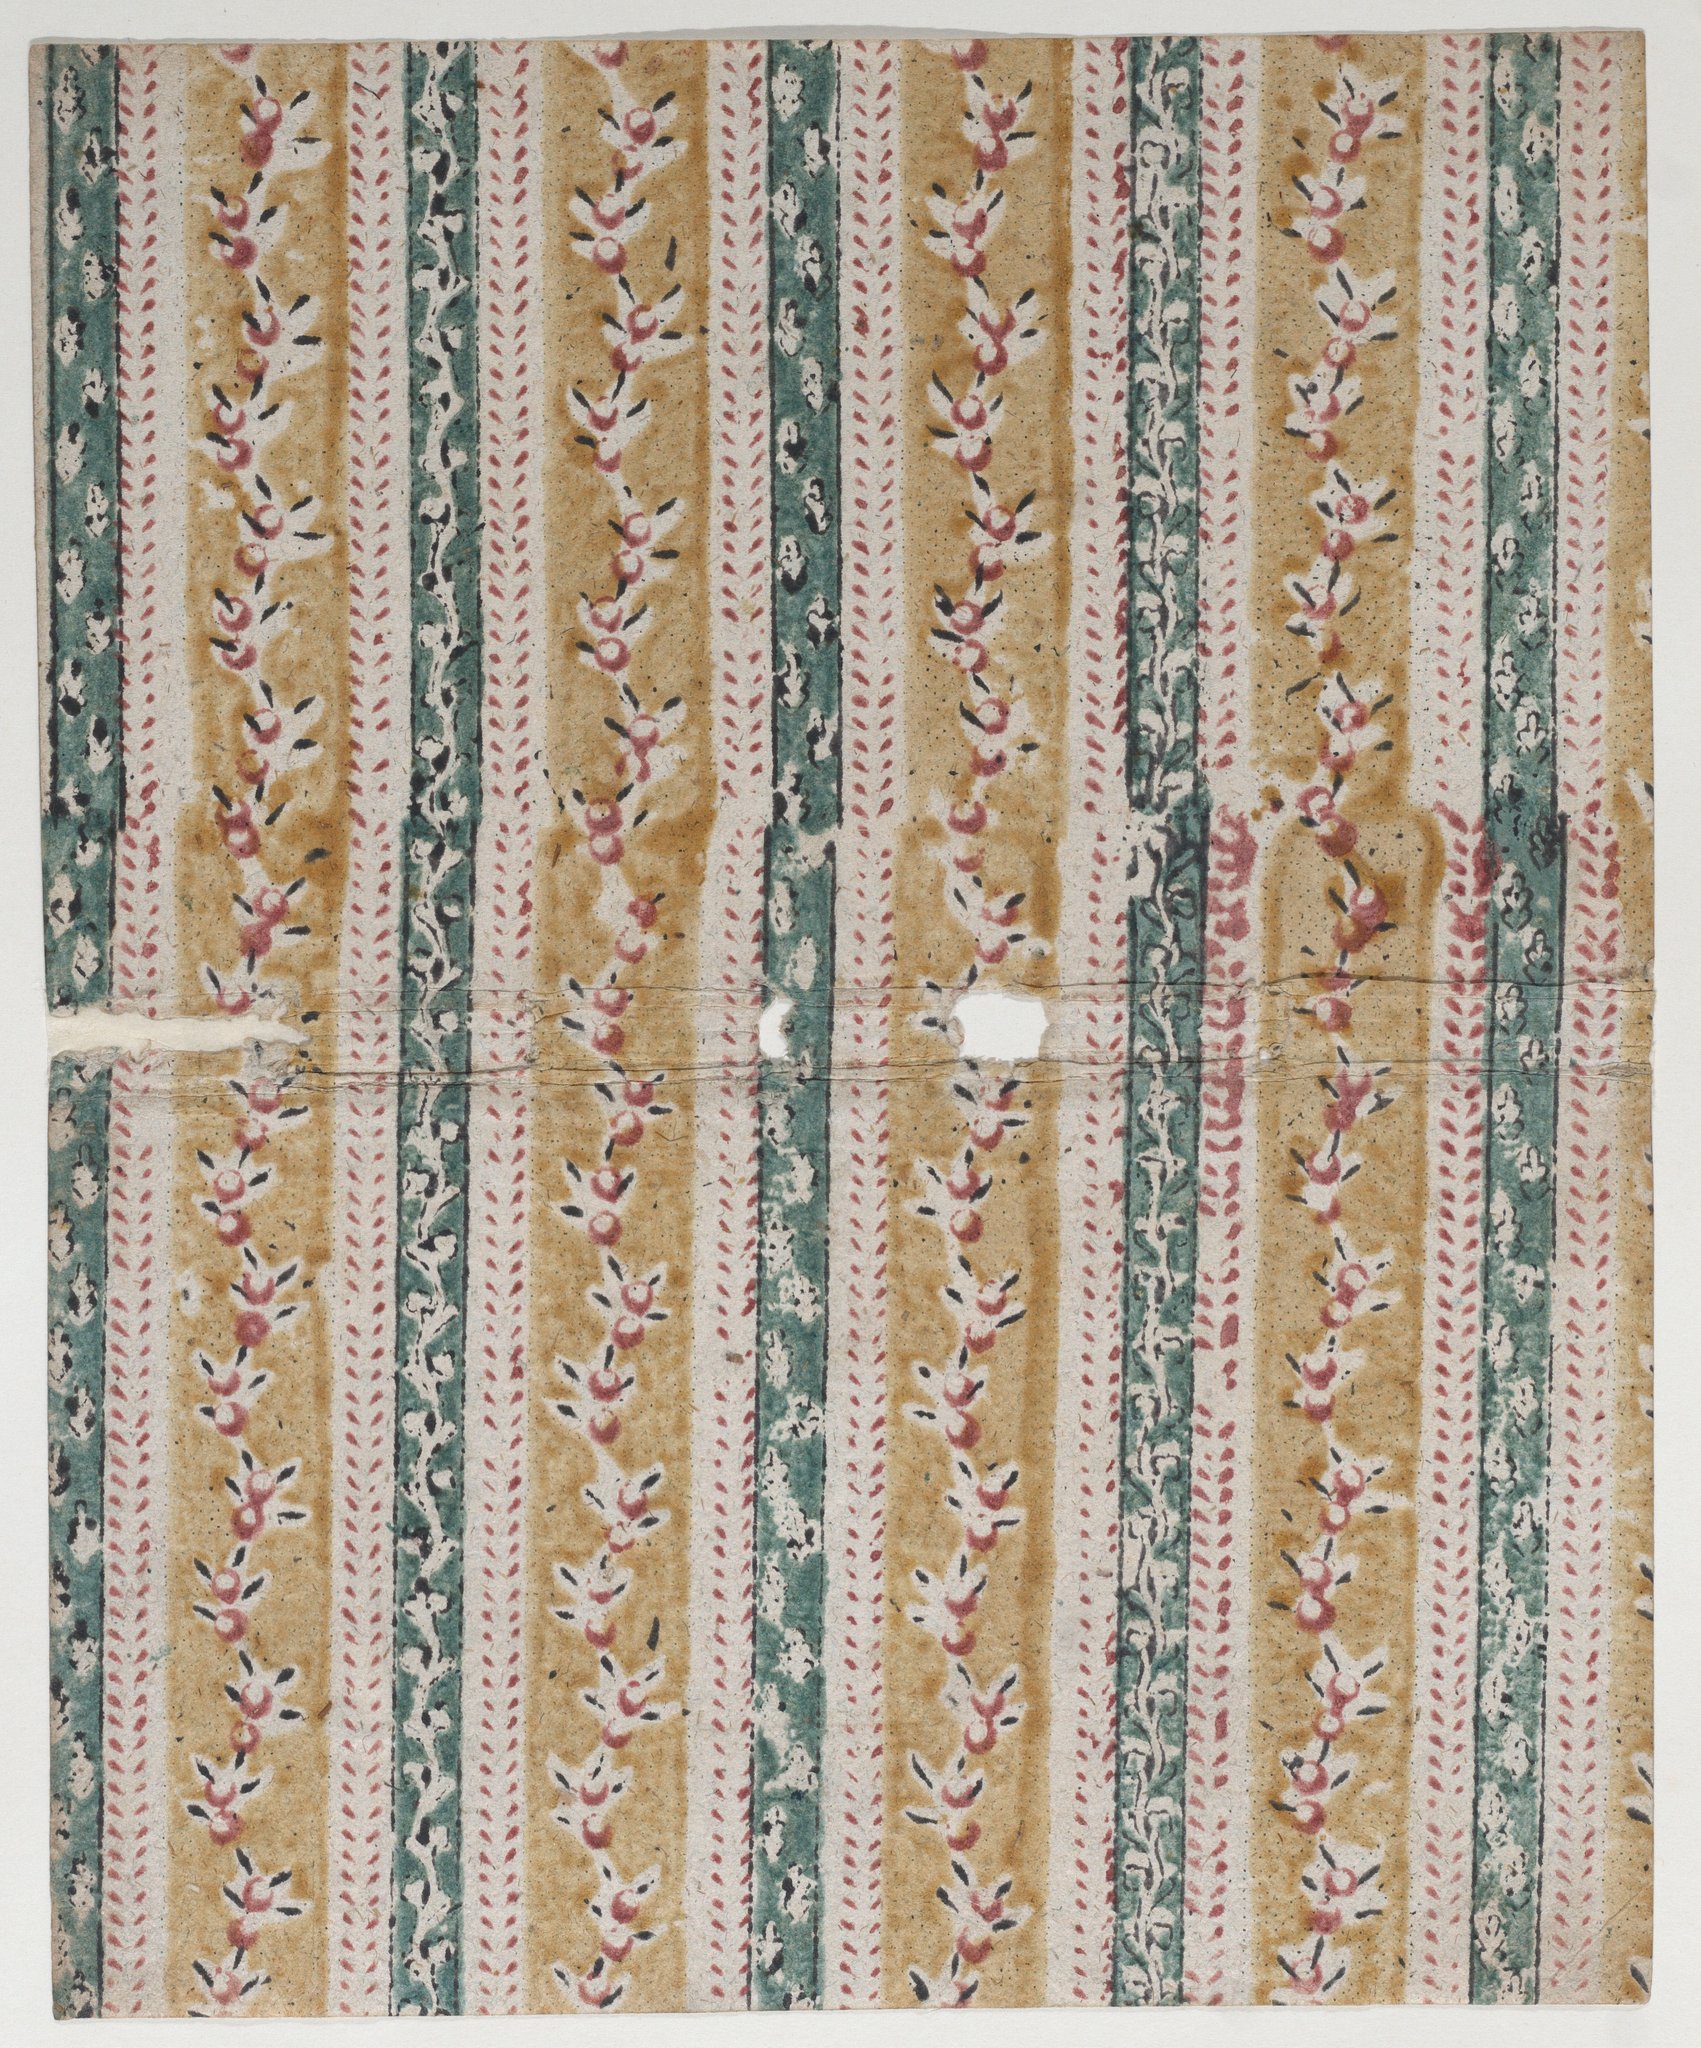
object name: print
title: Book cover with yellow and green striped floral pattern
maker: Anonymous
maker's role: artist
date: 1801-1900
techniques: relief print